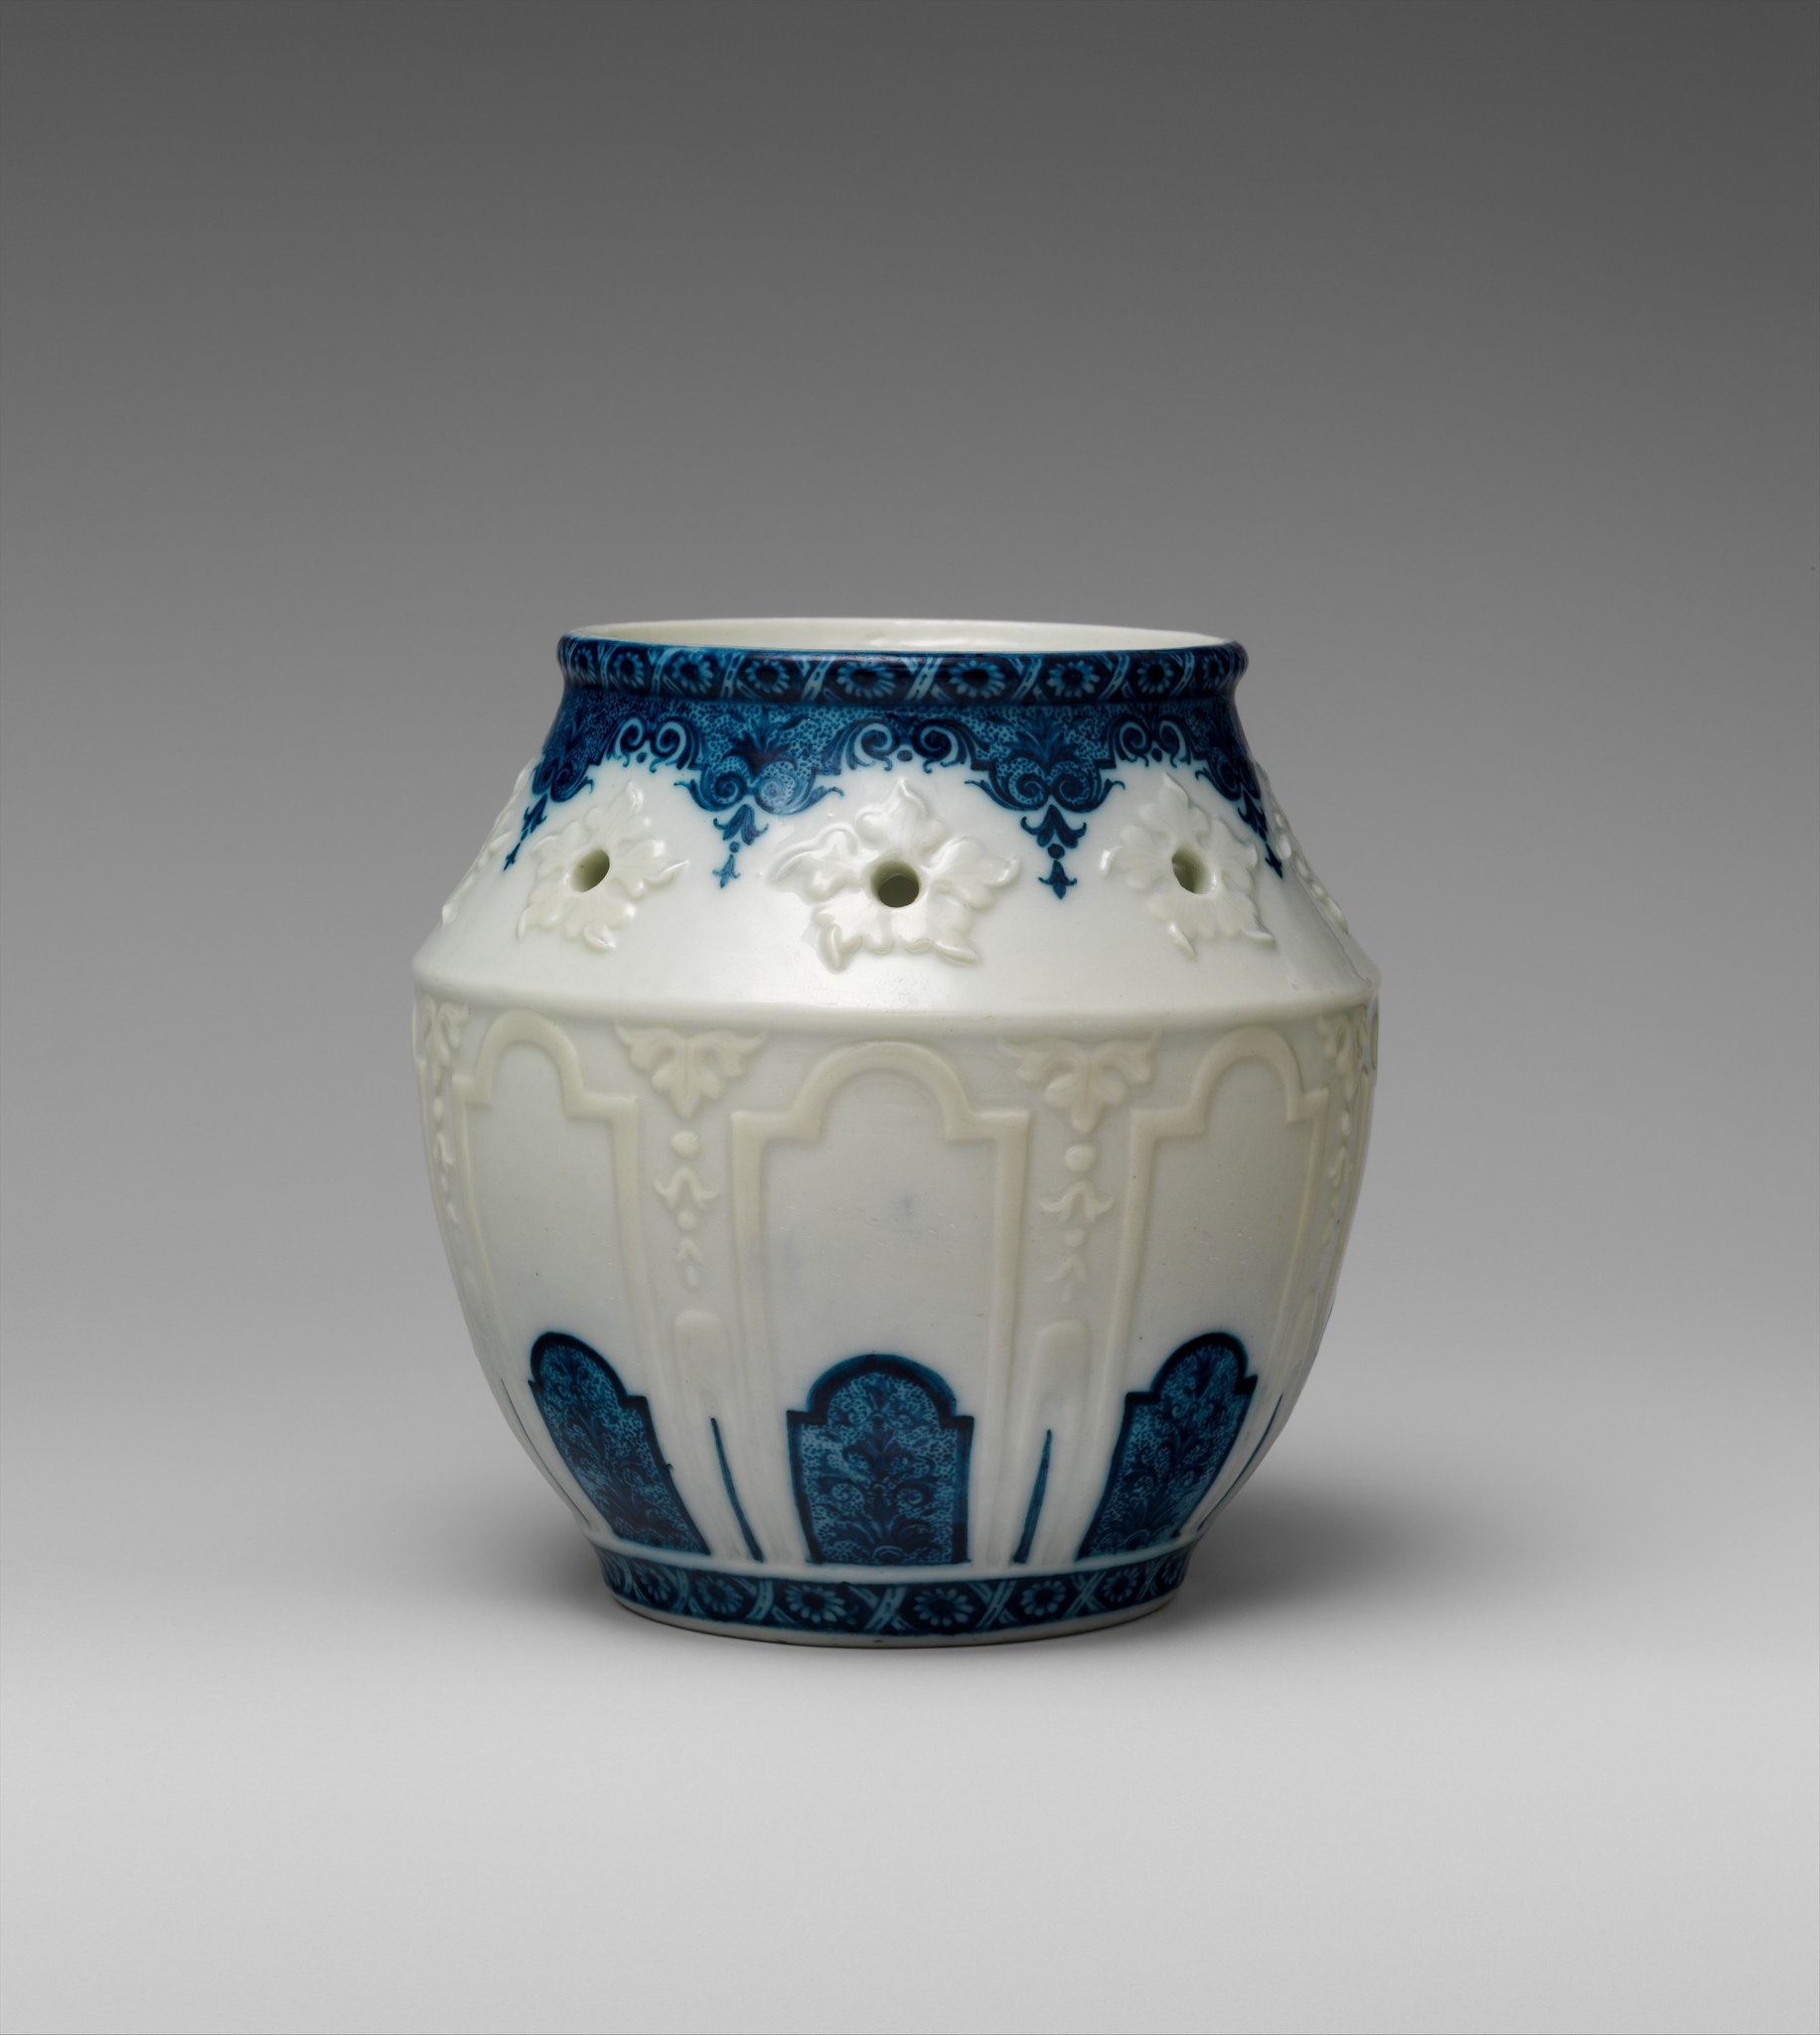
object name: potpourri jar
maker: louis poterat manufactory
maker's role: manufactory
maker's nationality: french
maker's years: 1690-1696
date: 1690-1695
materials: soft paste porcelain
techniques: underglaze